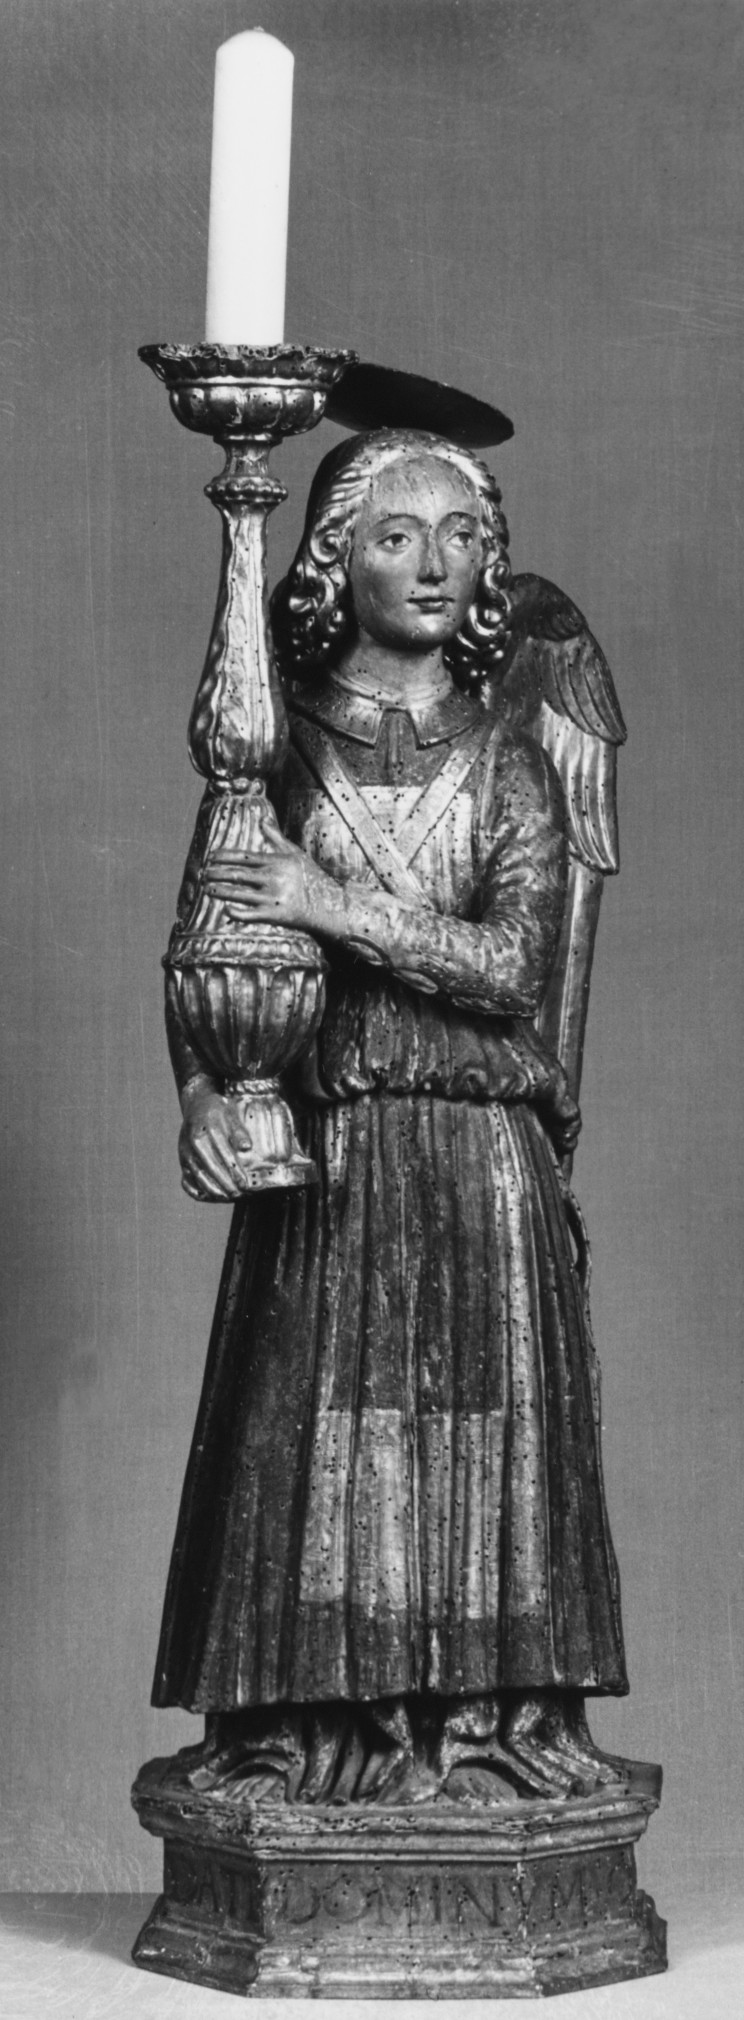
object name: candlestick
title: Pair of candlesticks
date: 1451-1500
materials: wood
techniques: carving, gilding, painting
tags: women